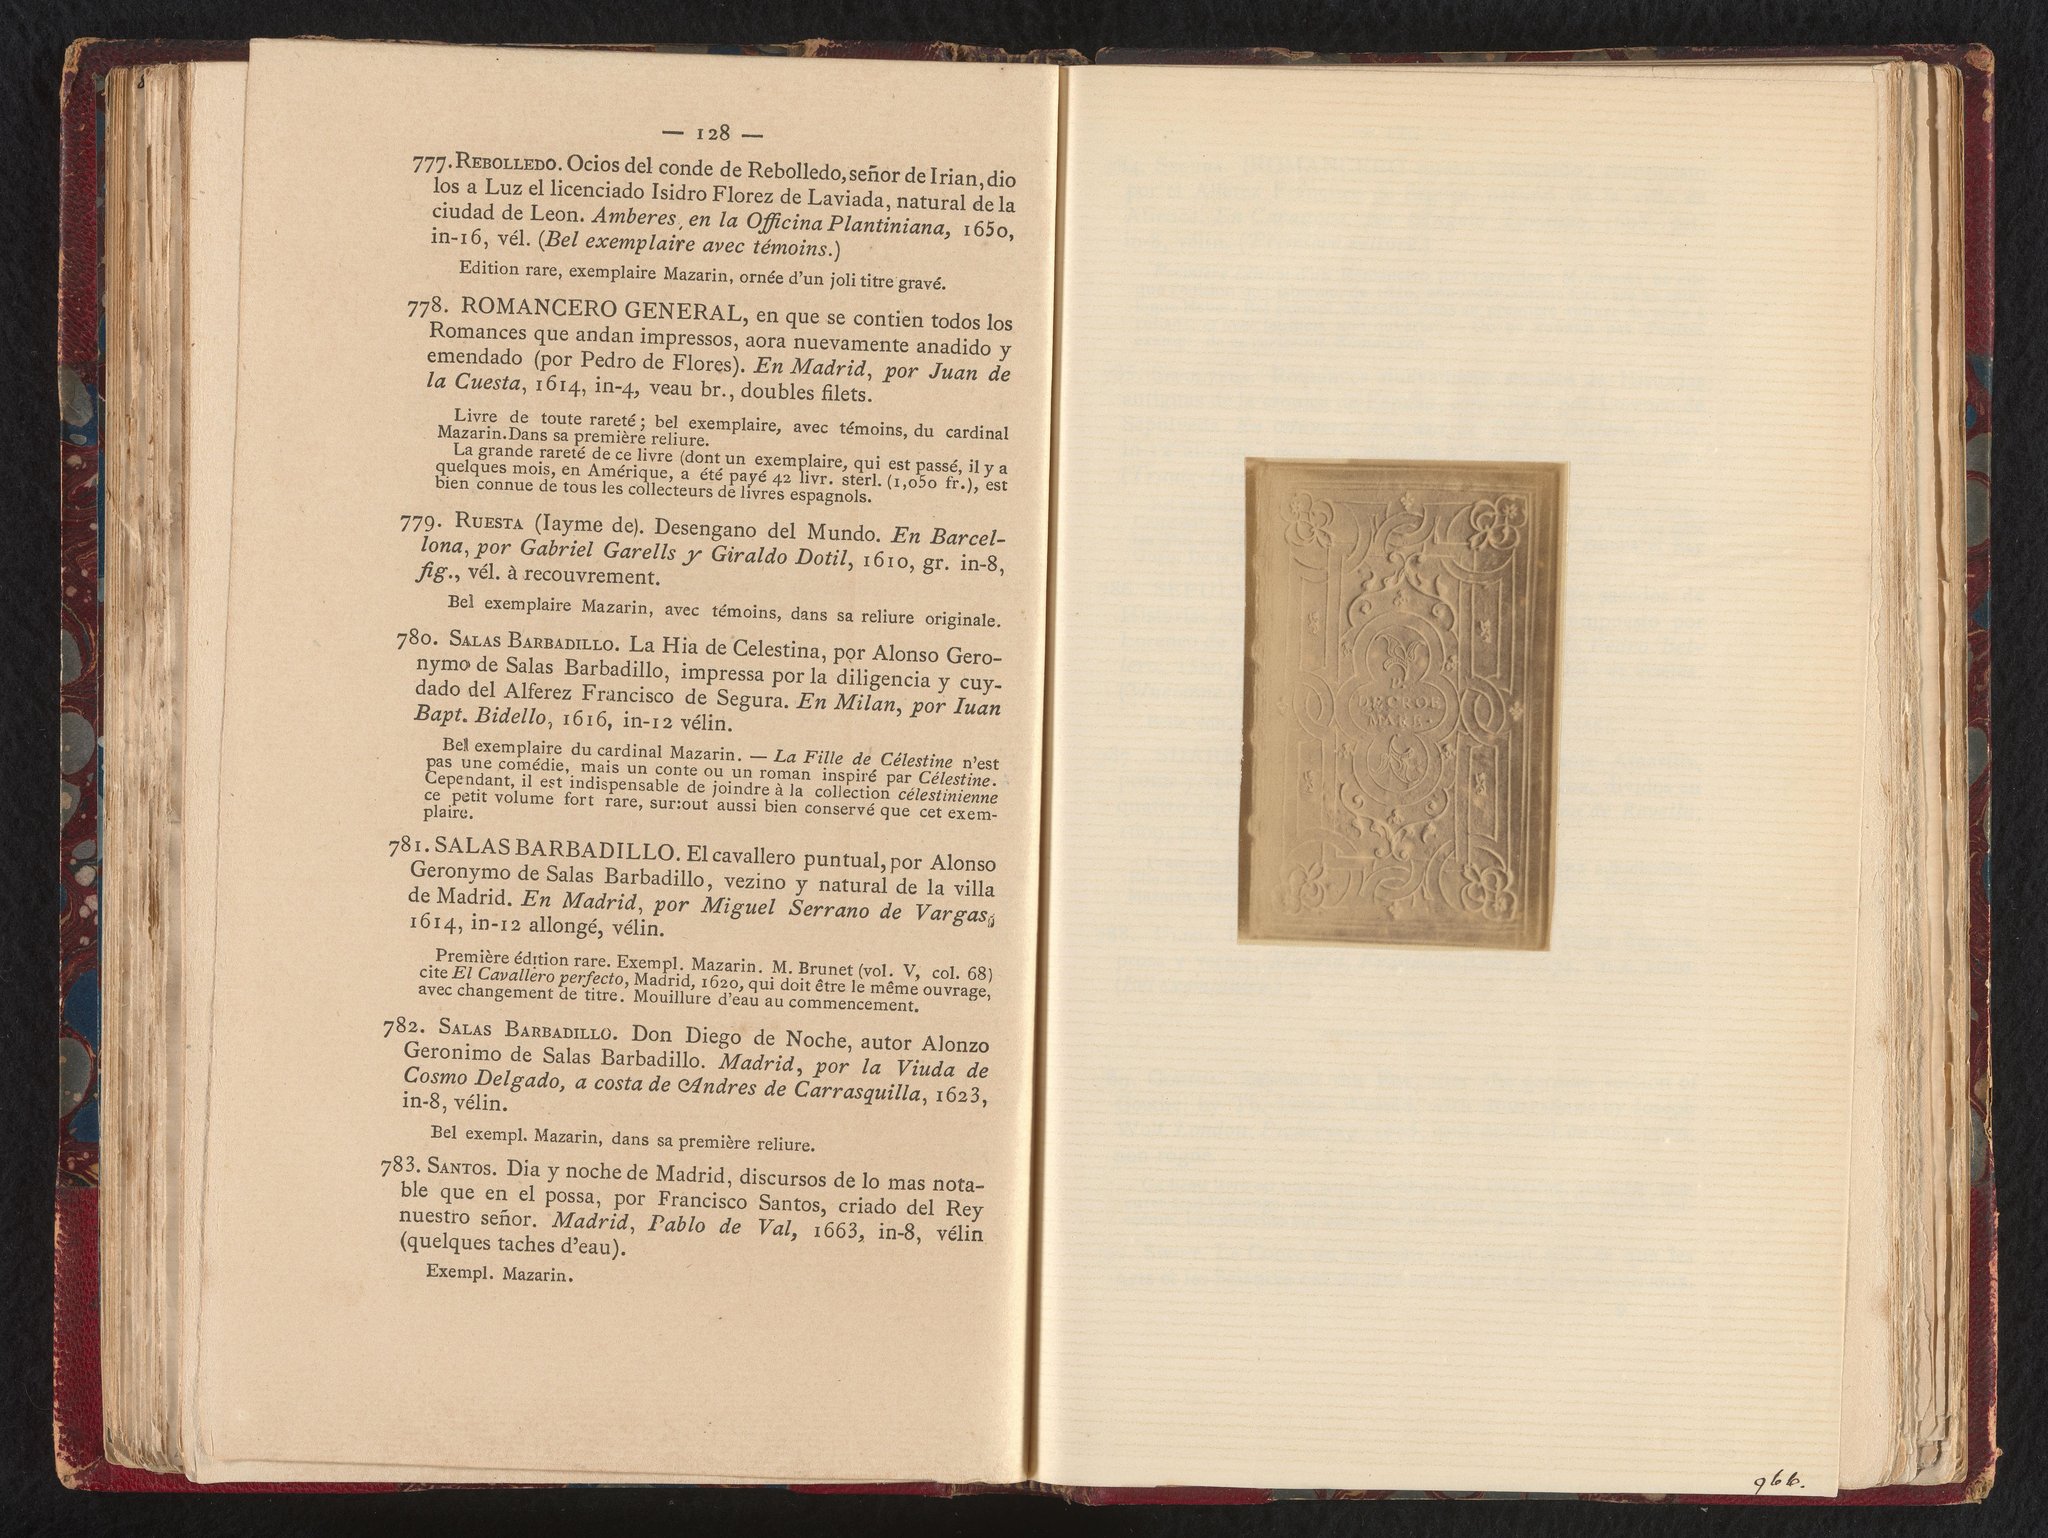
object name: page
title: Fotoreproductie van boekomslag van Caesaris (C. Iul.) Rerum ab se gestarum commentarii uit 1565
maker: Anonymous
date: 1863-1868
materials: paper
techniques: albumen print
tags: book-cover, binding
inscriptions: number: ‘966’